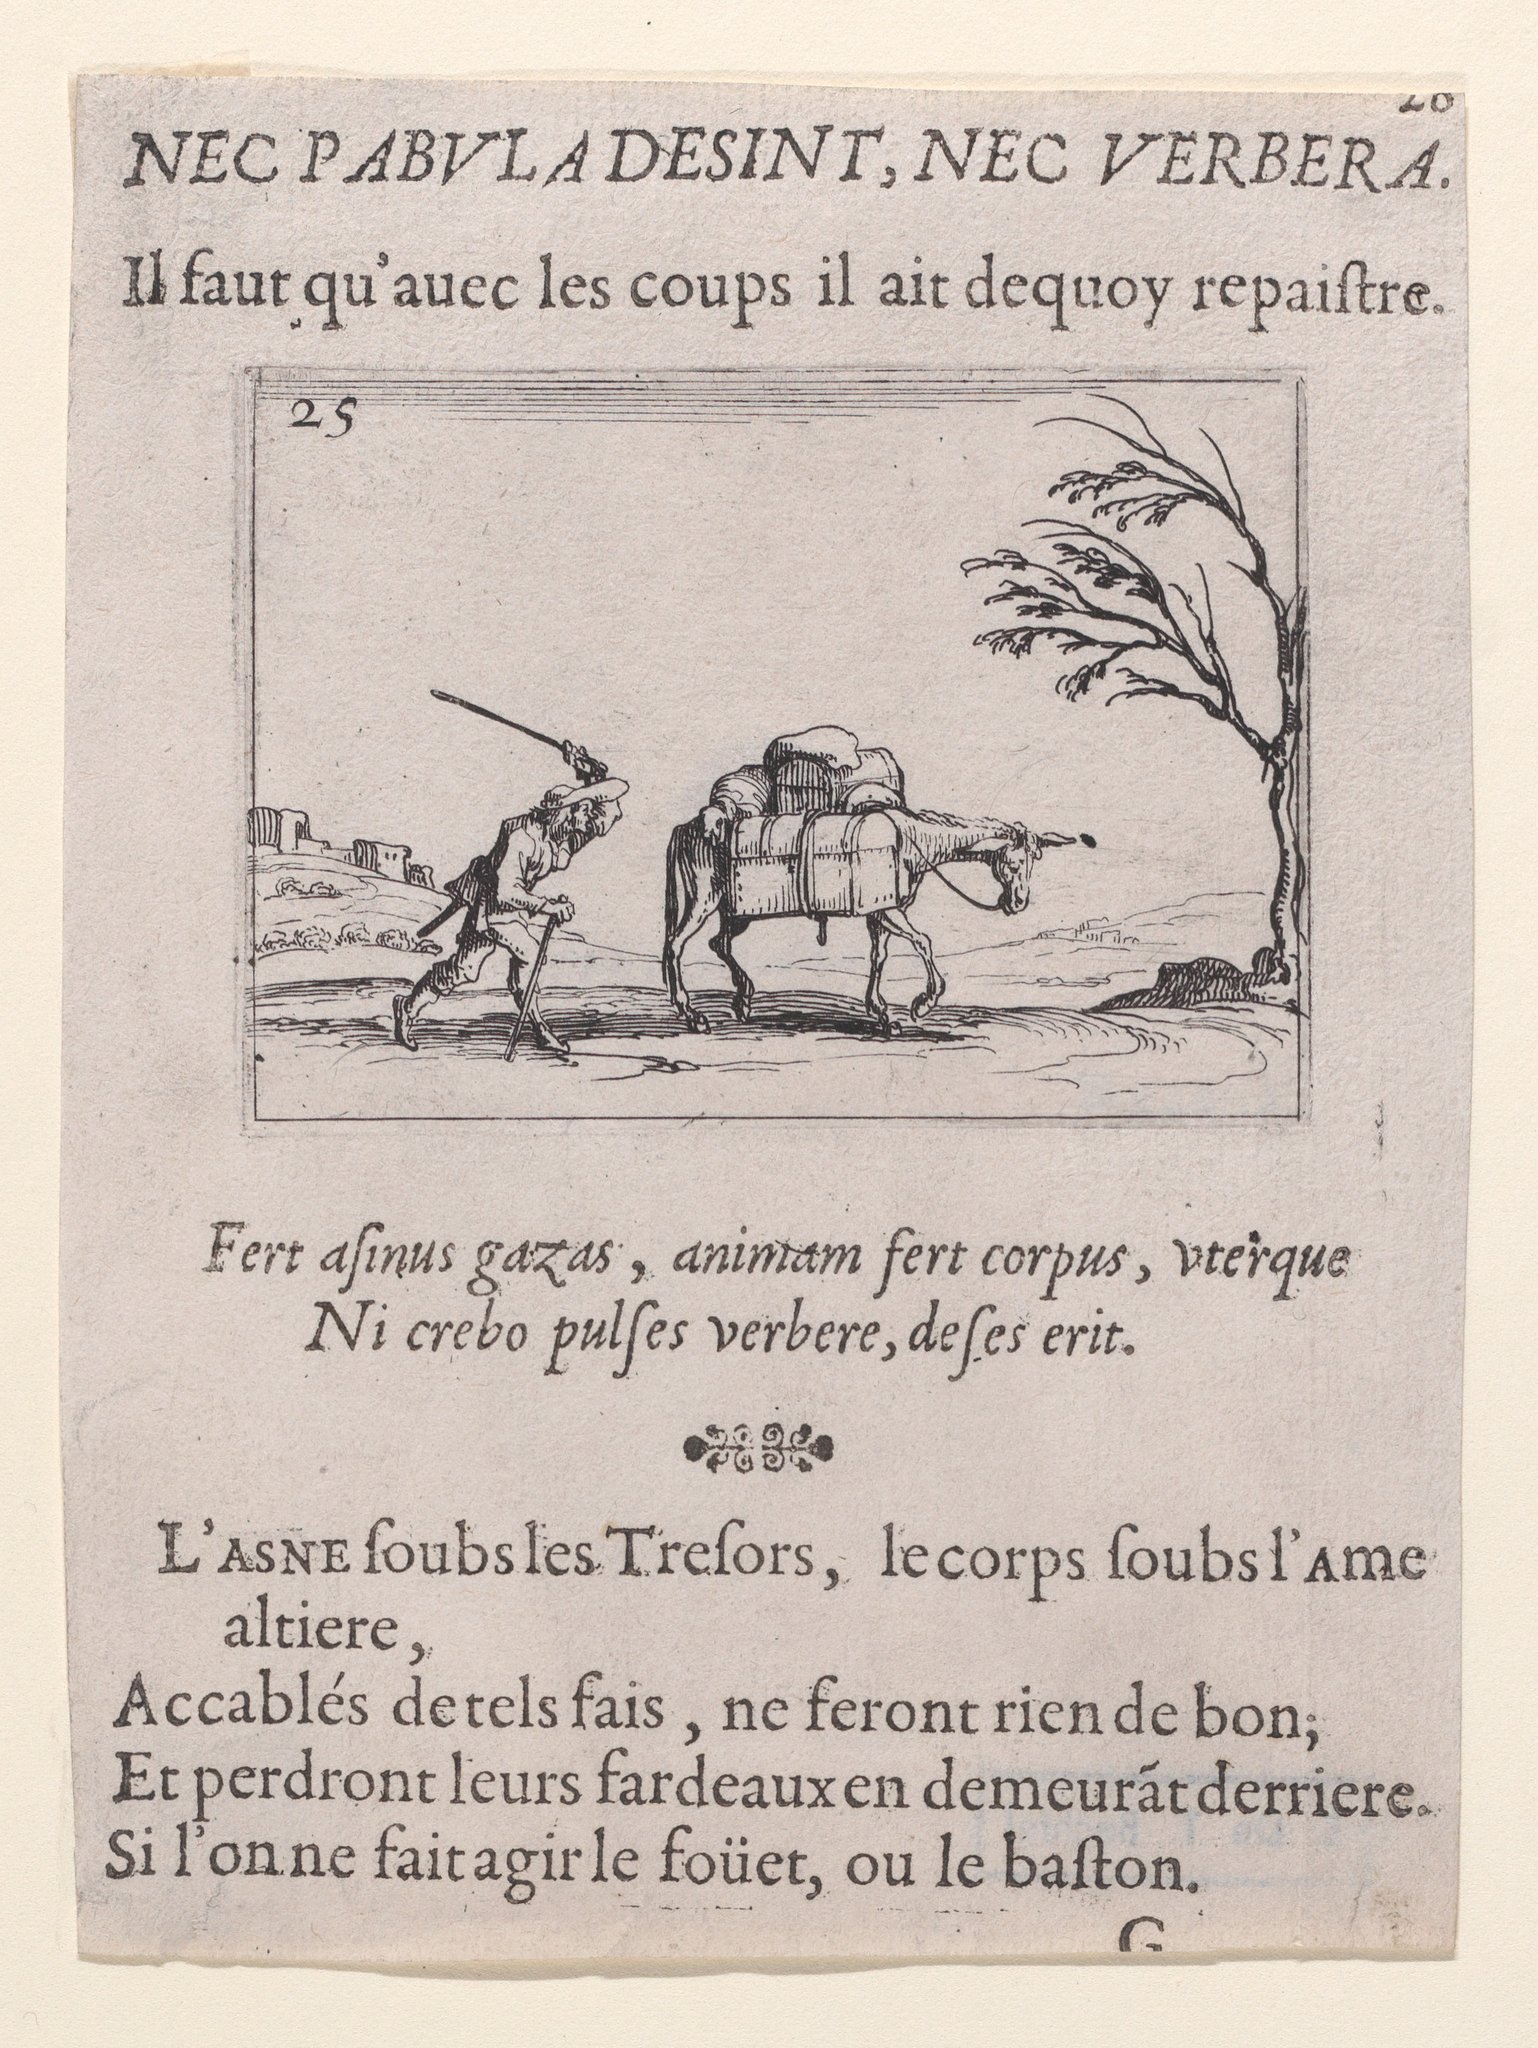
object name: print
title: Le Paysan Frappant son Ane (The Peasant Striking his Donkey), plate 25 from "Lux Claustri ou La Lumière du Cloitre" (The Light of the Cloisters)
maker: jacques callot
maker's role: artist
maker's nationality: french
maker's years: 1592-1635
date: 1621-1635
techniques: etching, letterpress